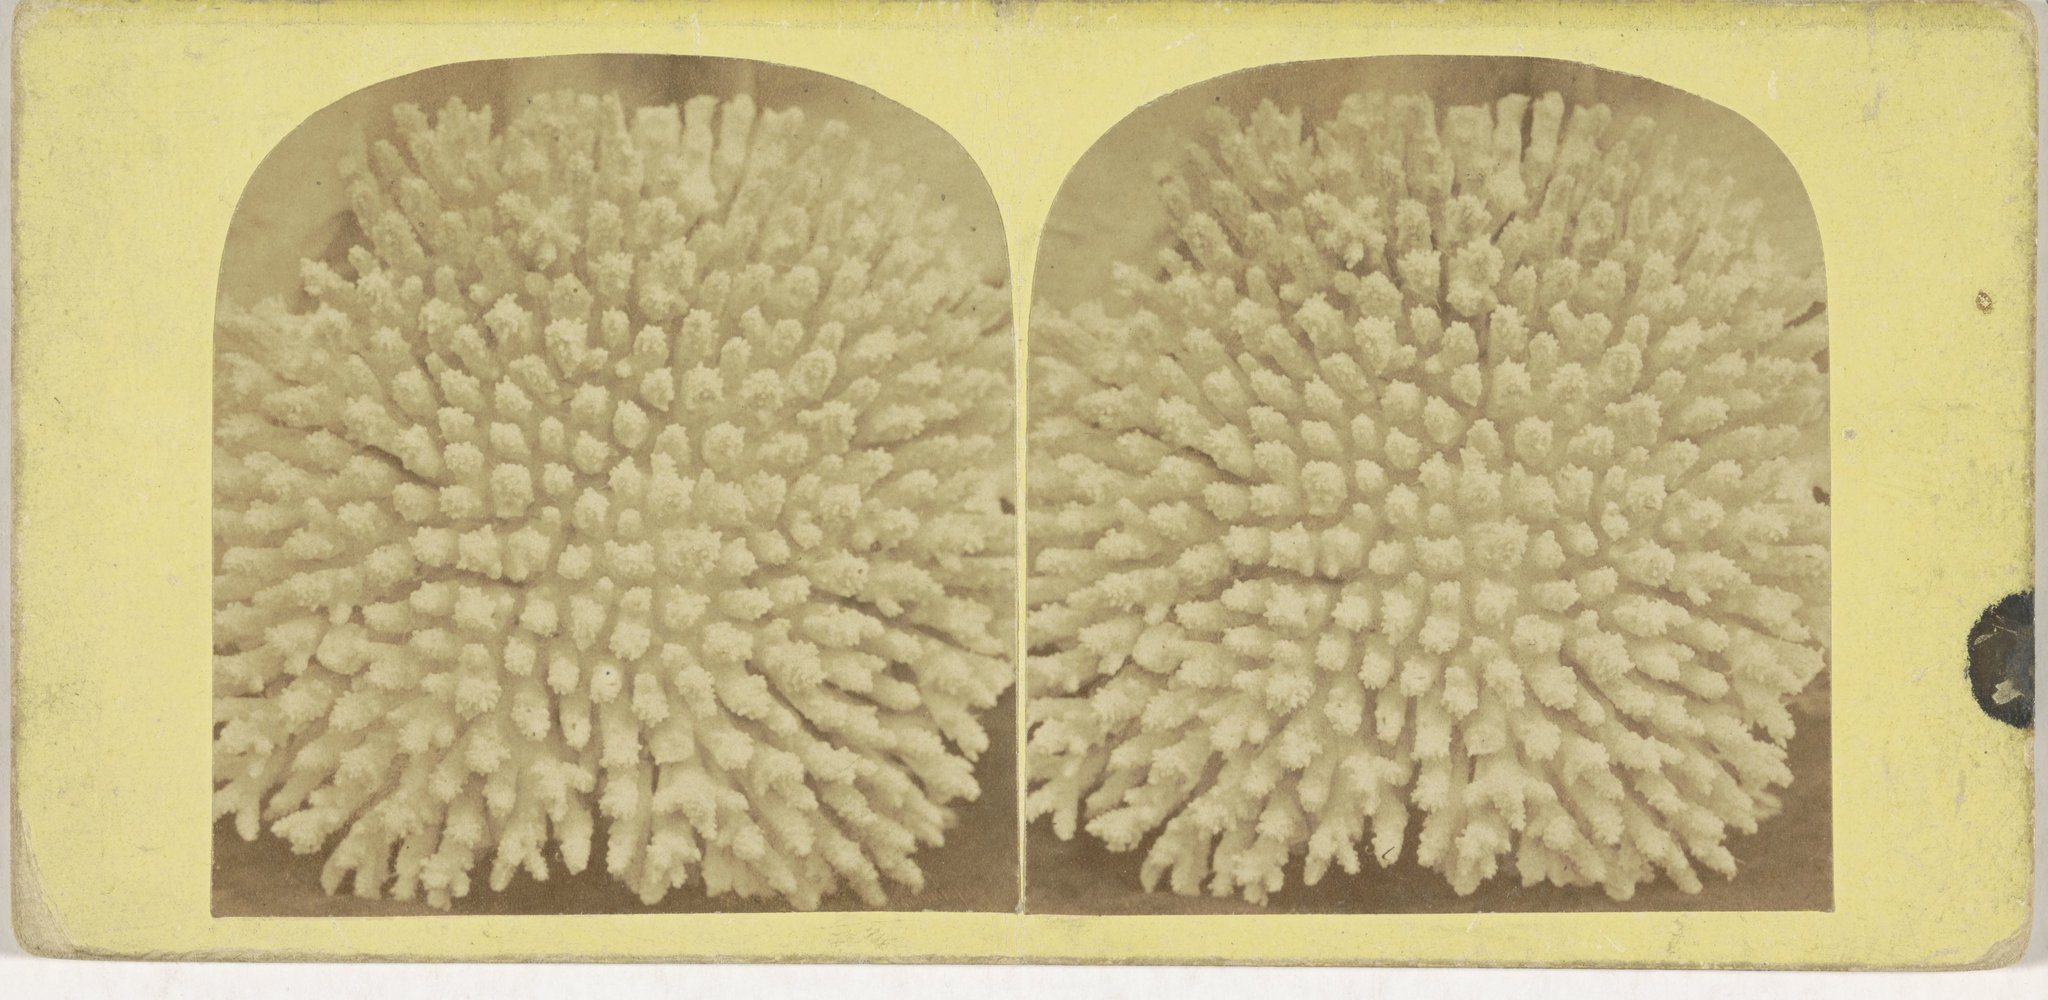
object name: stereograph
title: Koraal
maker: Anonymous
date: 1860-1890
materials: cardboard, paper, photographic support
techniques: albumen print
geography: utrecht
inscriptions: inscription: ‘82’, stamp: ‘NOLET [?] & ZOON / UTRECHT / OUDE / GRACHT’